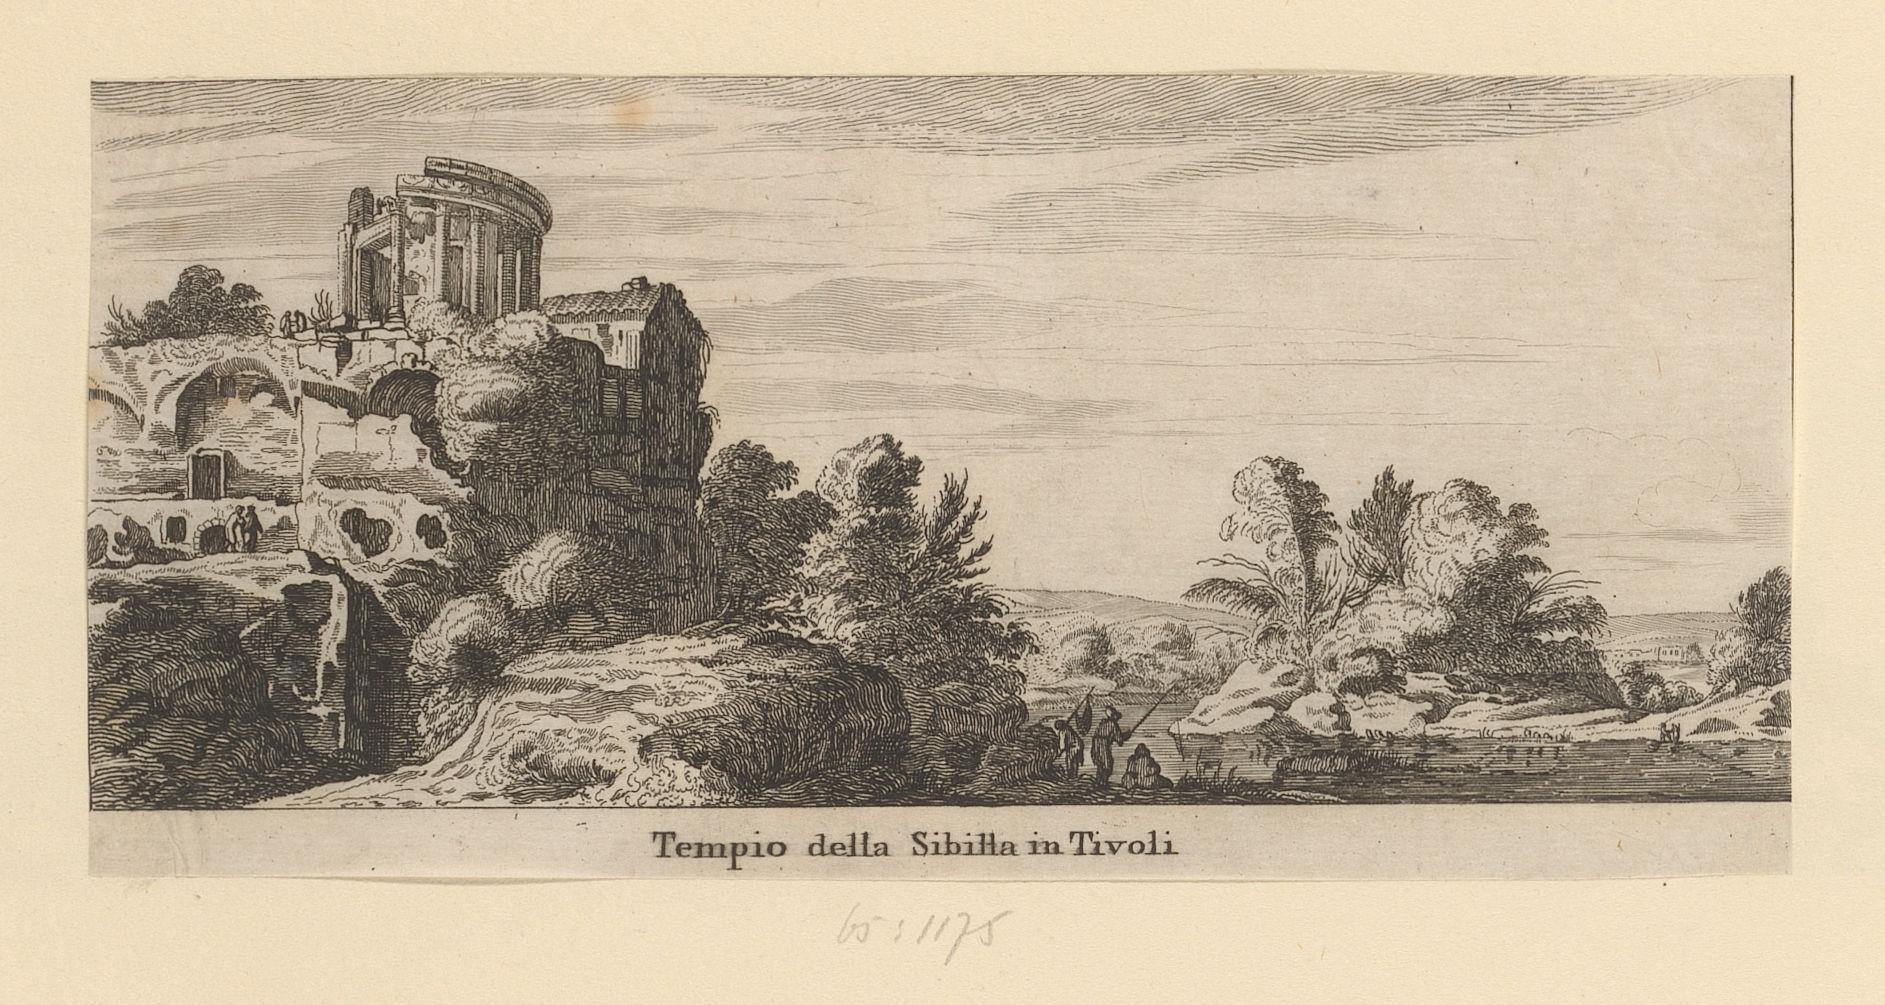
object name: album leaf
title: Antiche et moderne vedute di Romae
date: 1638-1799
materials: paper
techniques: etching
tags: landscape with ruins (+ city(-scape) with figures, staffage)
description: Prent maakt mogelijk deel uit van een serie van 200 prenten. Deze serie is onder de titel 'A Collection of two hundred original etchings' voor het eerst uitgegeven door J.M. Greery in 1816.